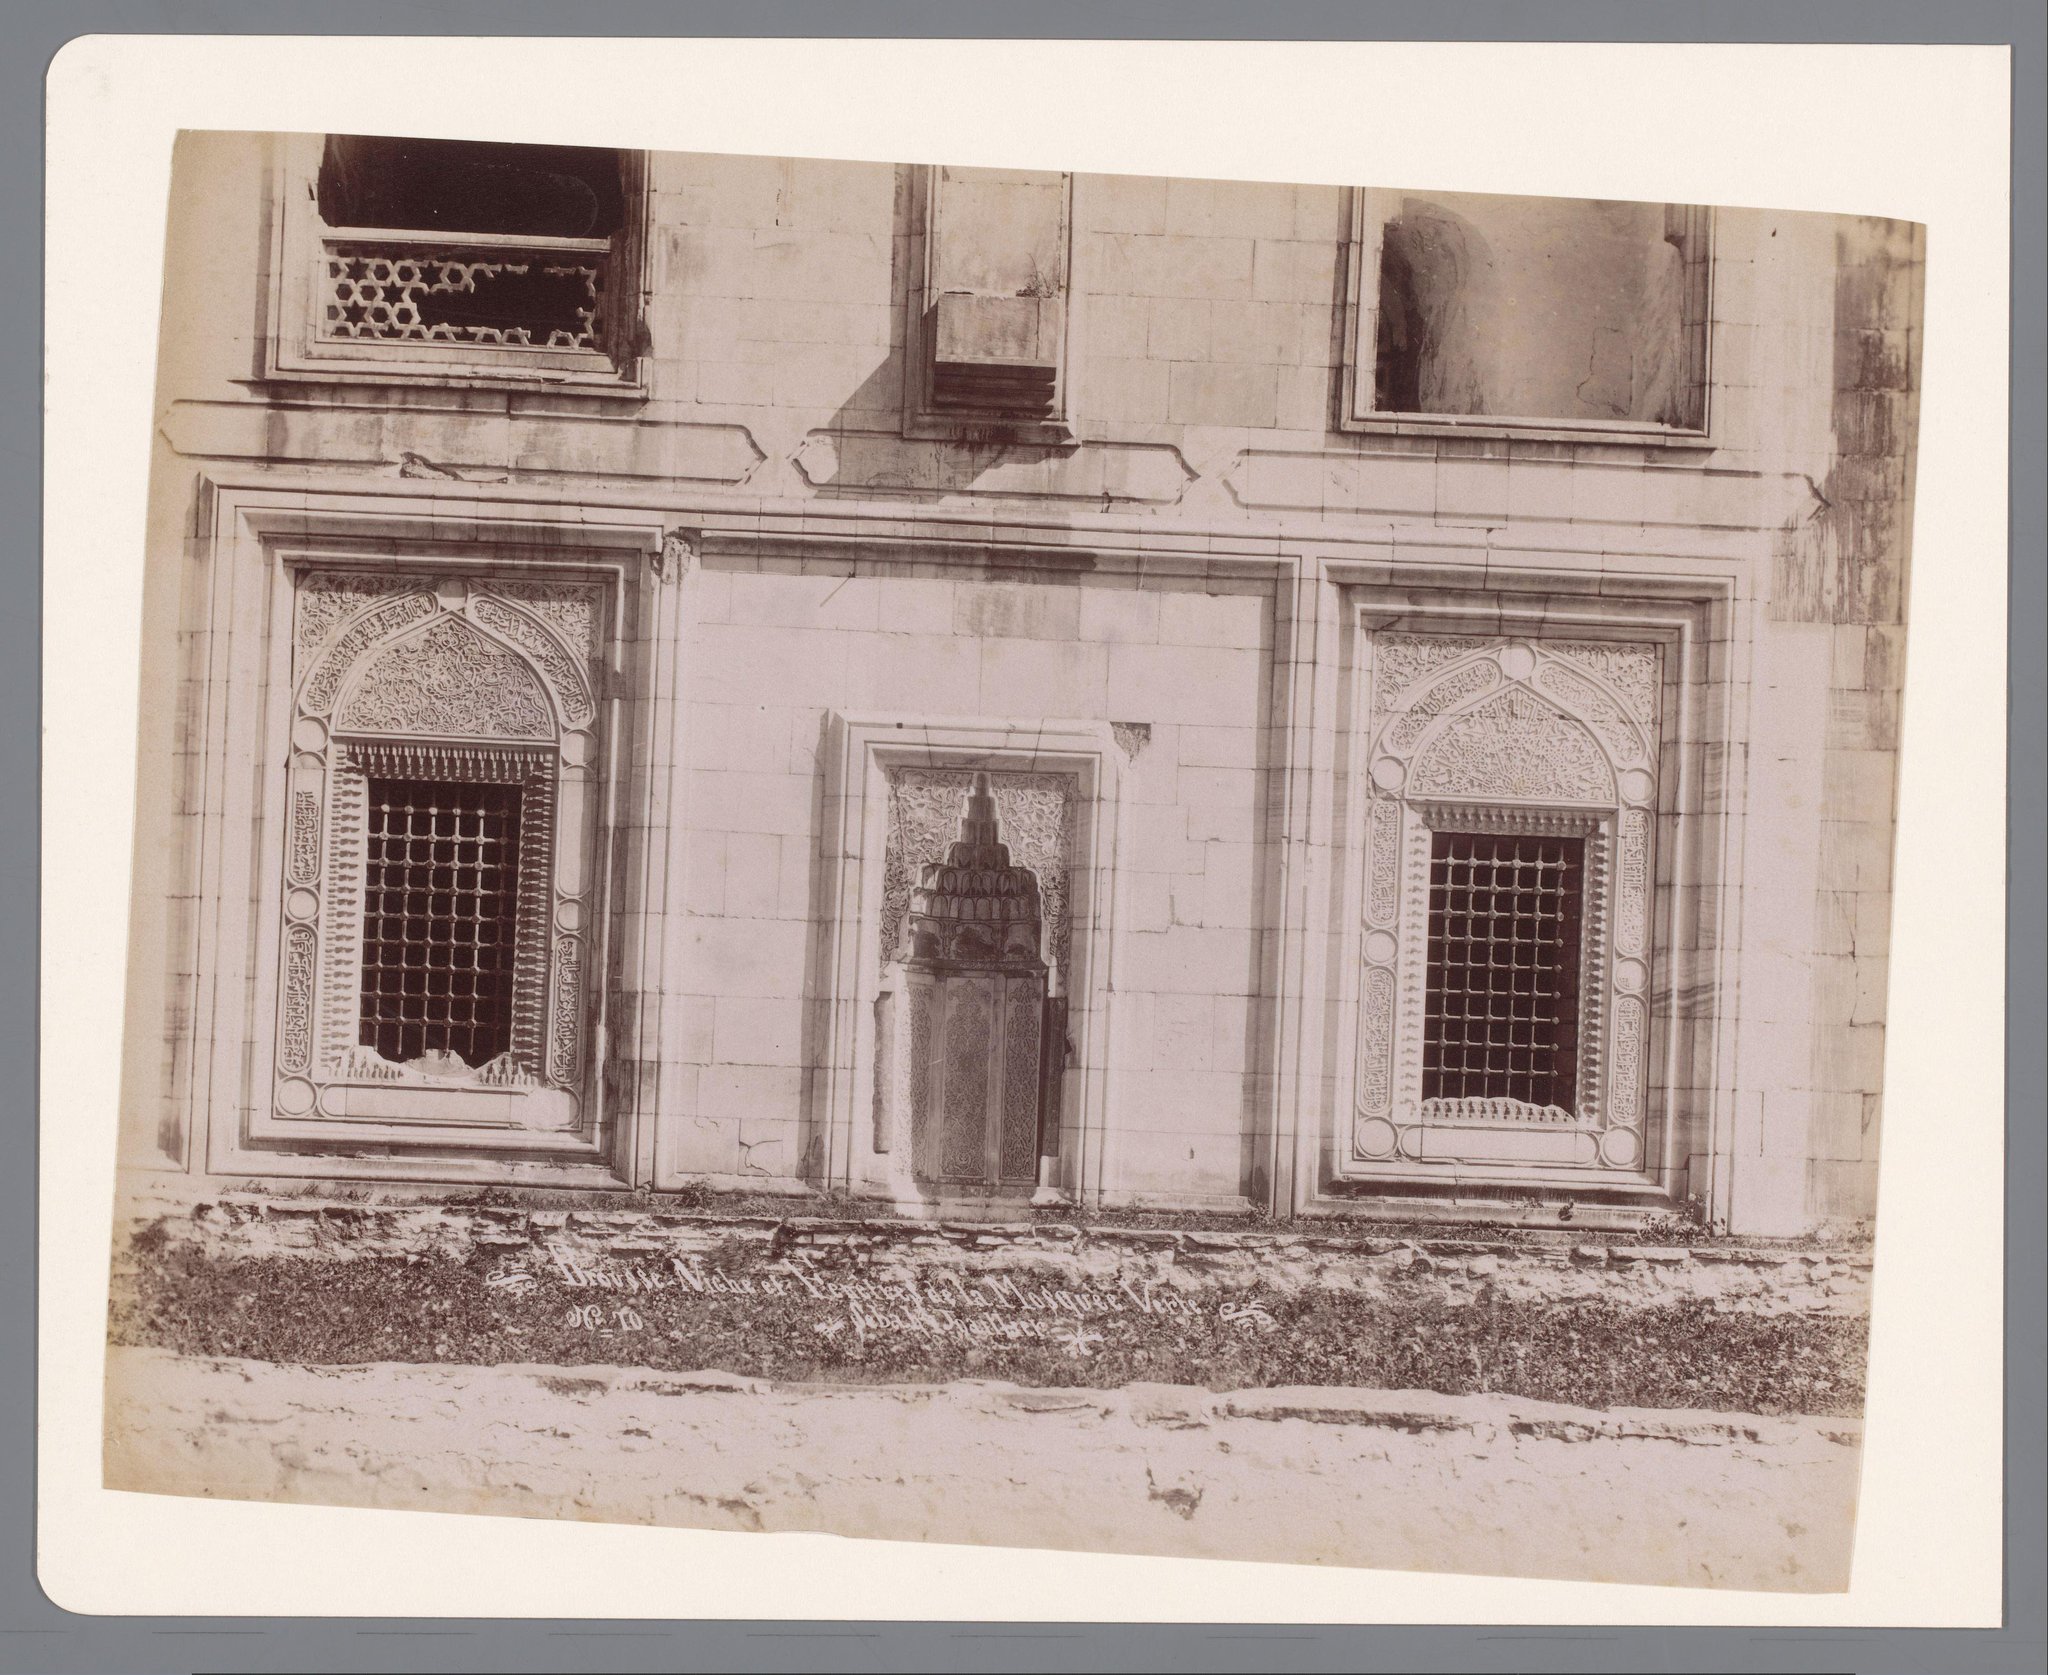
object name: photograph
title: Façade van de Groene Moskee in Bursa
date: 1888-1900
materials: paper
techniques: albumen print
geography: bursa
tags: temple, shrine ~ islam, mohammedanism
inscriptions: number: ‘No 70’